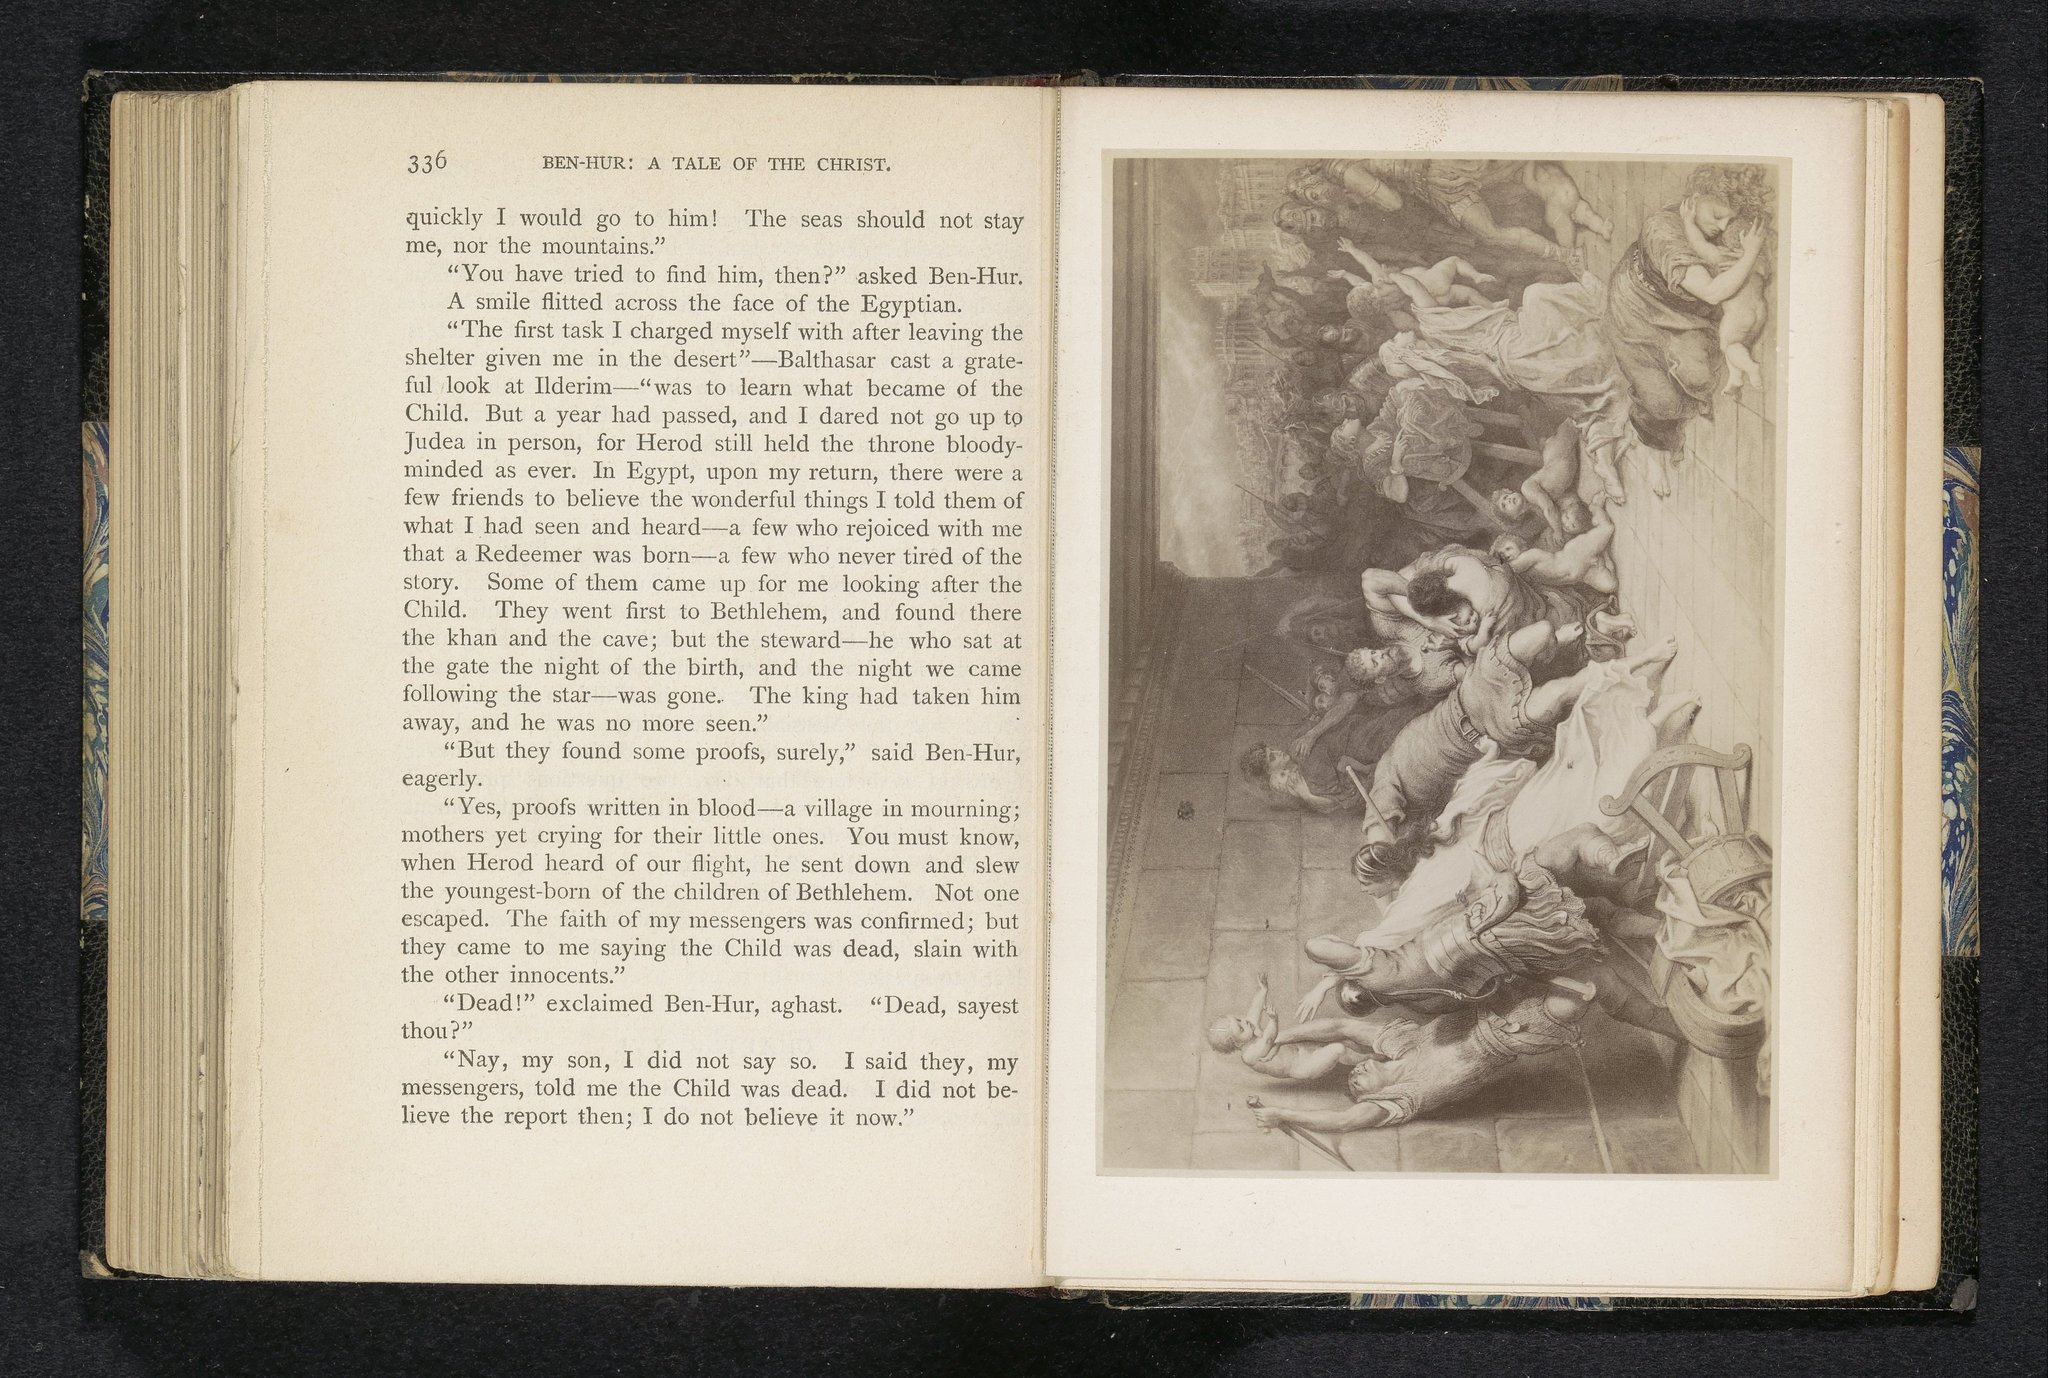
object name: reproduction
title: Fotoreproductie van een prent, voorstellende de Kindermoord van Bethlehem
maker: Anonymous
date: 1883-1888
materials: photographic support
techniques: albumen print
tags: the massacre of the innocents